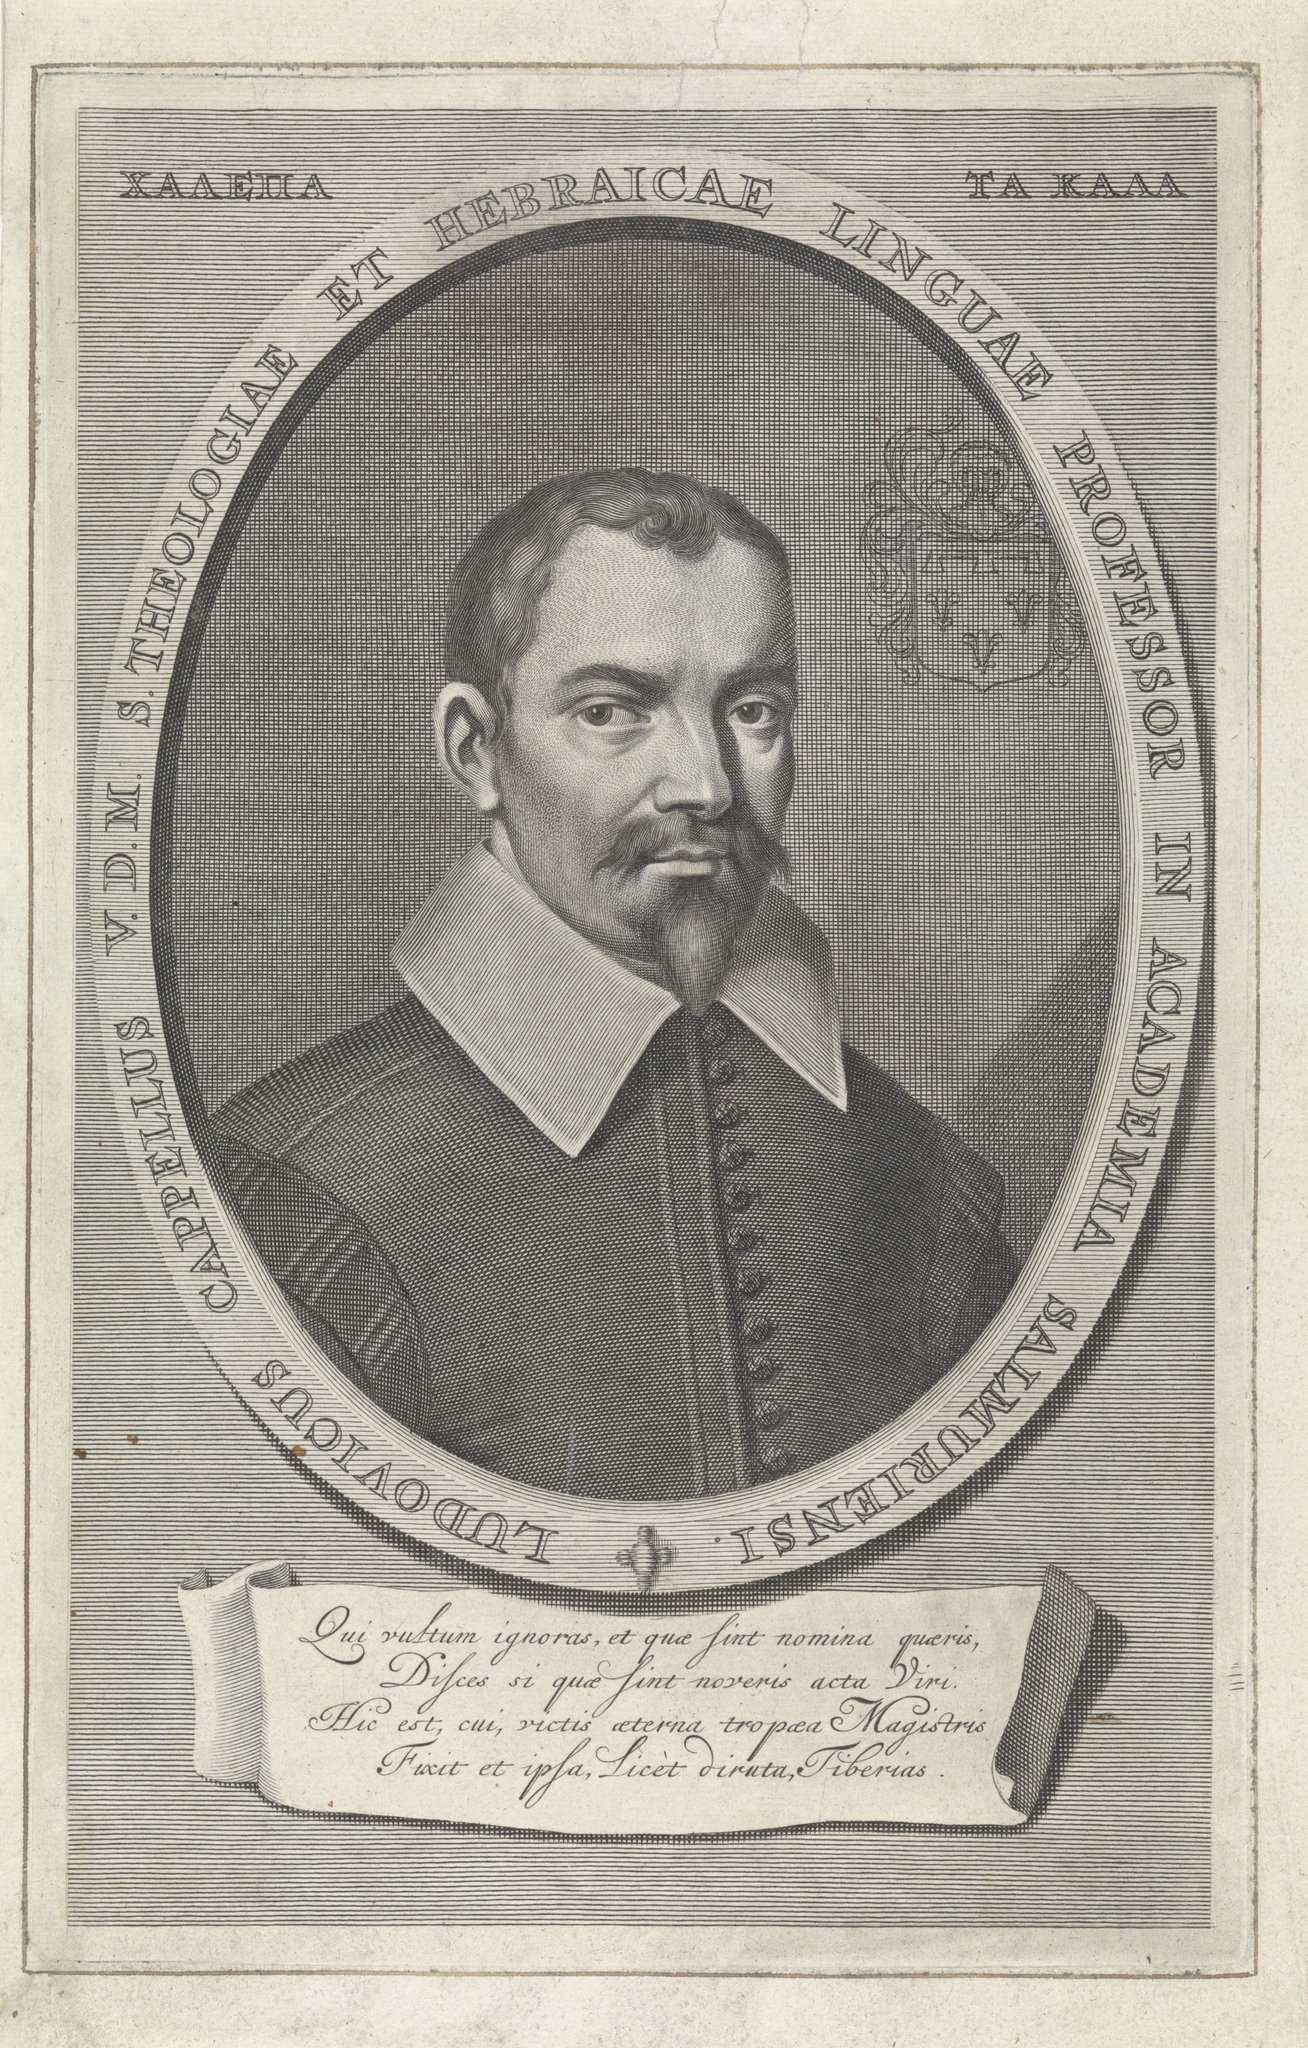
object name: print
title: Portret van Lodewijk Cappellus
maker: anthony van zijlvelt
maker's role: print maker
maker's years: 1637-1715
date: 1650-1695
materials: paper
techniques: engraving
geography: amsterdam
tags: paris, theologian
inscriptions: : ‘Qui vultum ignoras...diruta Tiberias.’, title: ‘LUDOVICUS CAPPELLUS V.D.M. S. THEOLOGIAE ET HEBRAICAELINGUAE PROFESSOR IN ACADEMIA SALMURIENSI.’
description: Portret van de theoloog Lodewijk Cappellus met zijn wapenschild op de achtergrond, in ovale omlijsting. Onder het portret een vierregelige tekst in het Latijn.